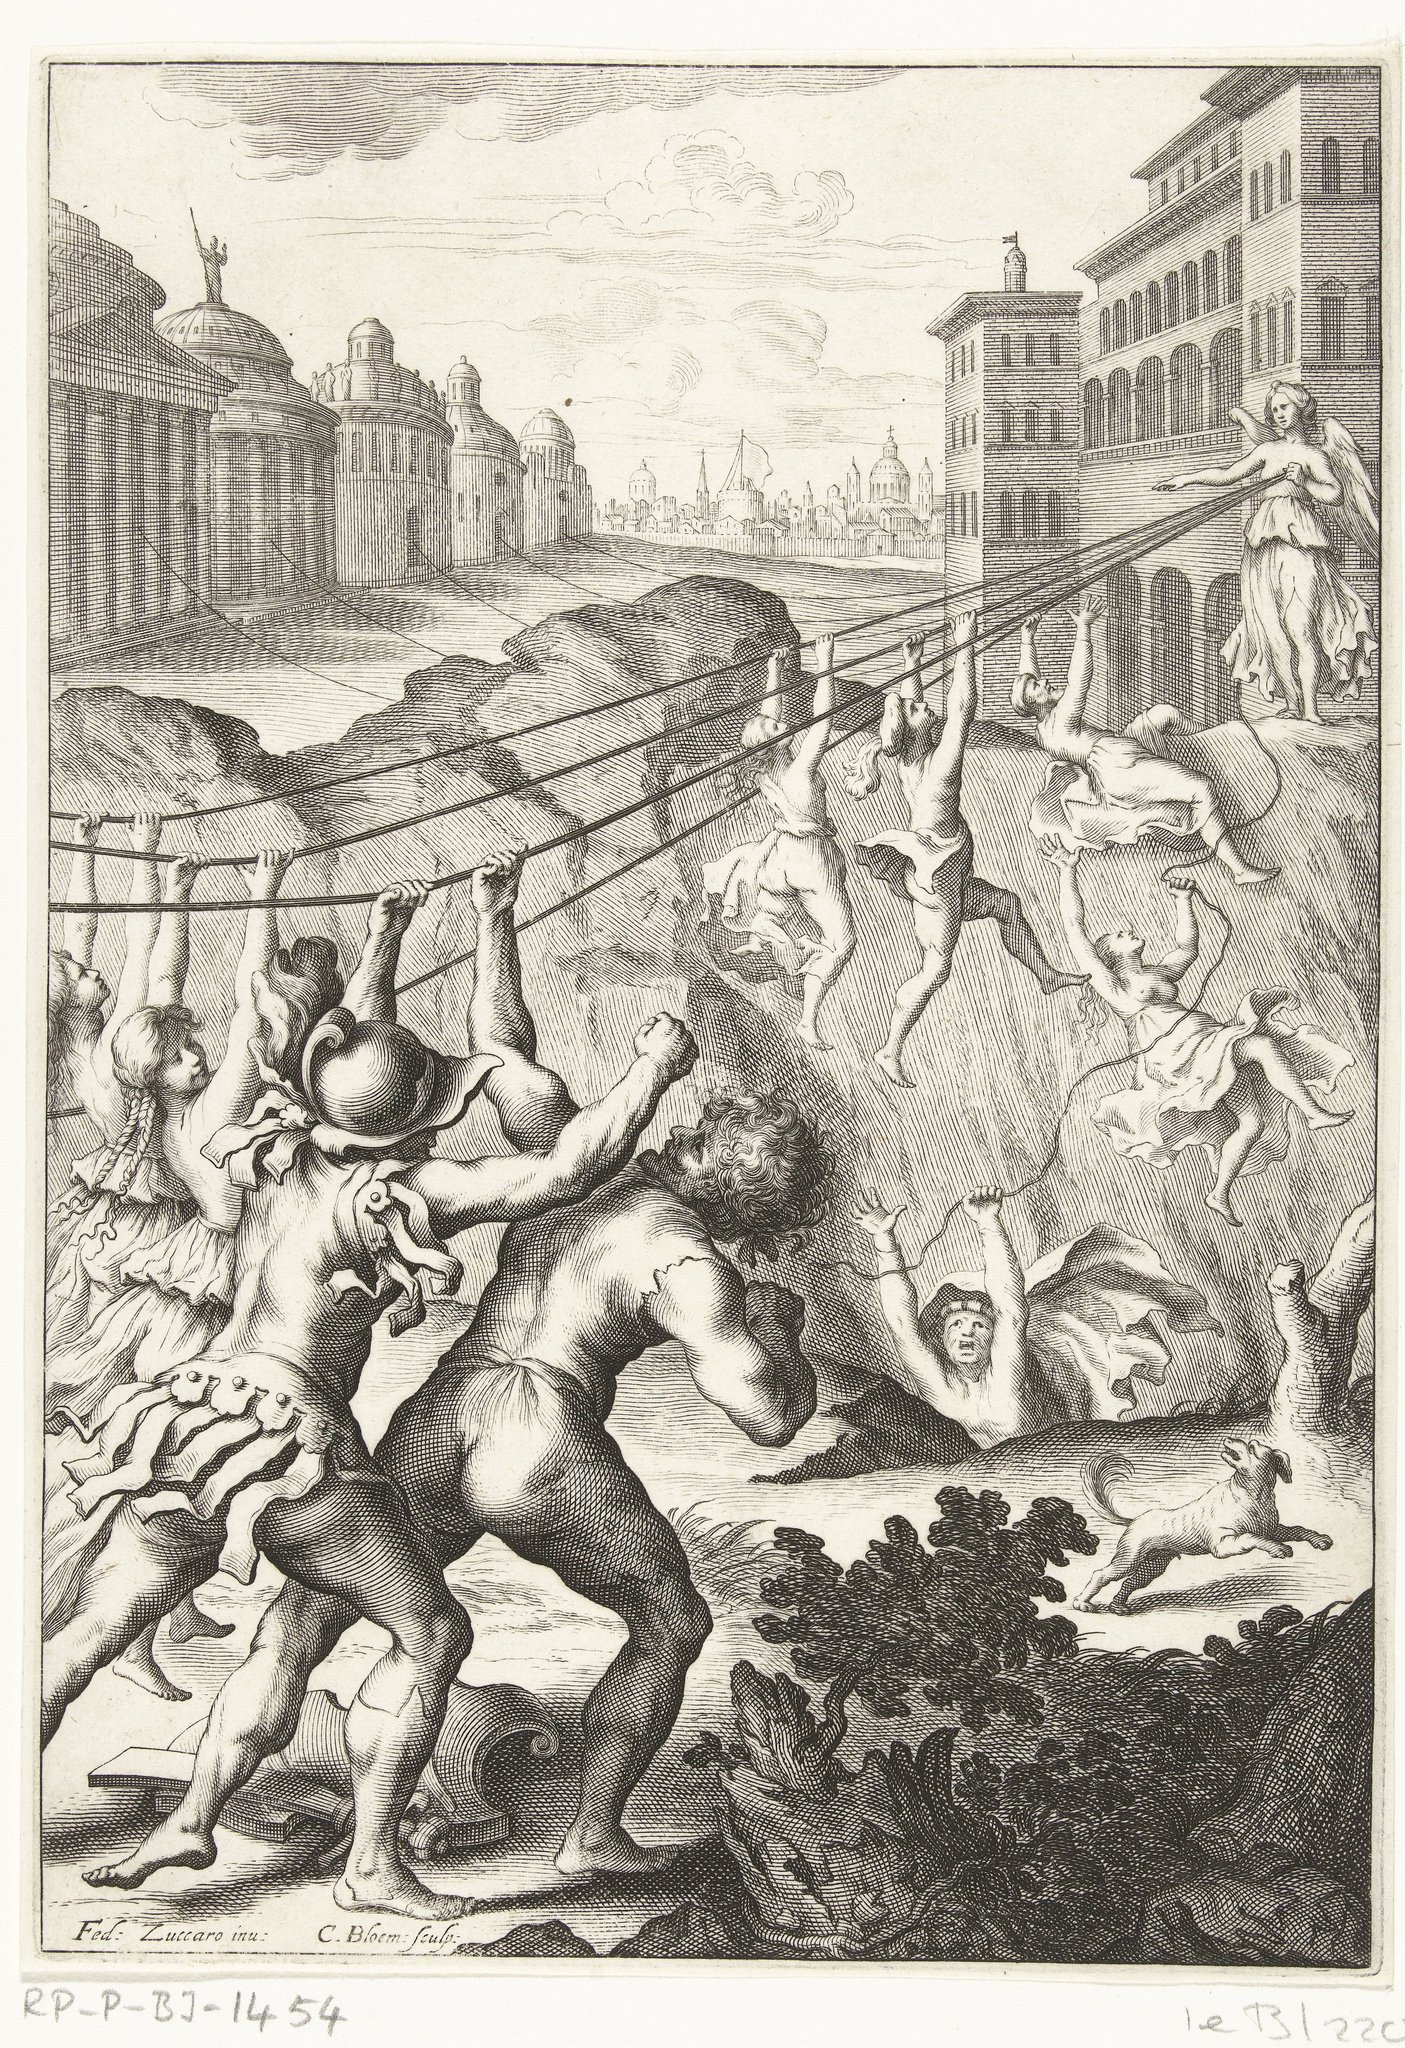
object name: book illustration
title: Hoop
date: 1640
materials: paper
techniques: engraving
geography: rome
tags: hope; 'speranza', 'speranza delle fatiche' (ripa), pylons, power lines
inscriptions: collector's mark: Lugt 2228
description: Mannen en vrouwen van verschillende leeftijden spannen zich in om aan een koord de overkant van een ravijn te bereiken. Een engel staat aan de overkant en houdt de koorden vast. Illustratie voor het hoofdstuk Sotto Speranza uit het boek Documenti d'Amore.